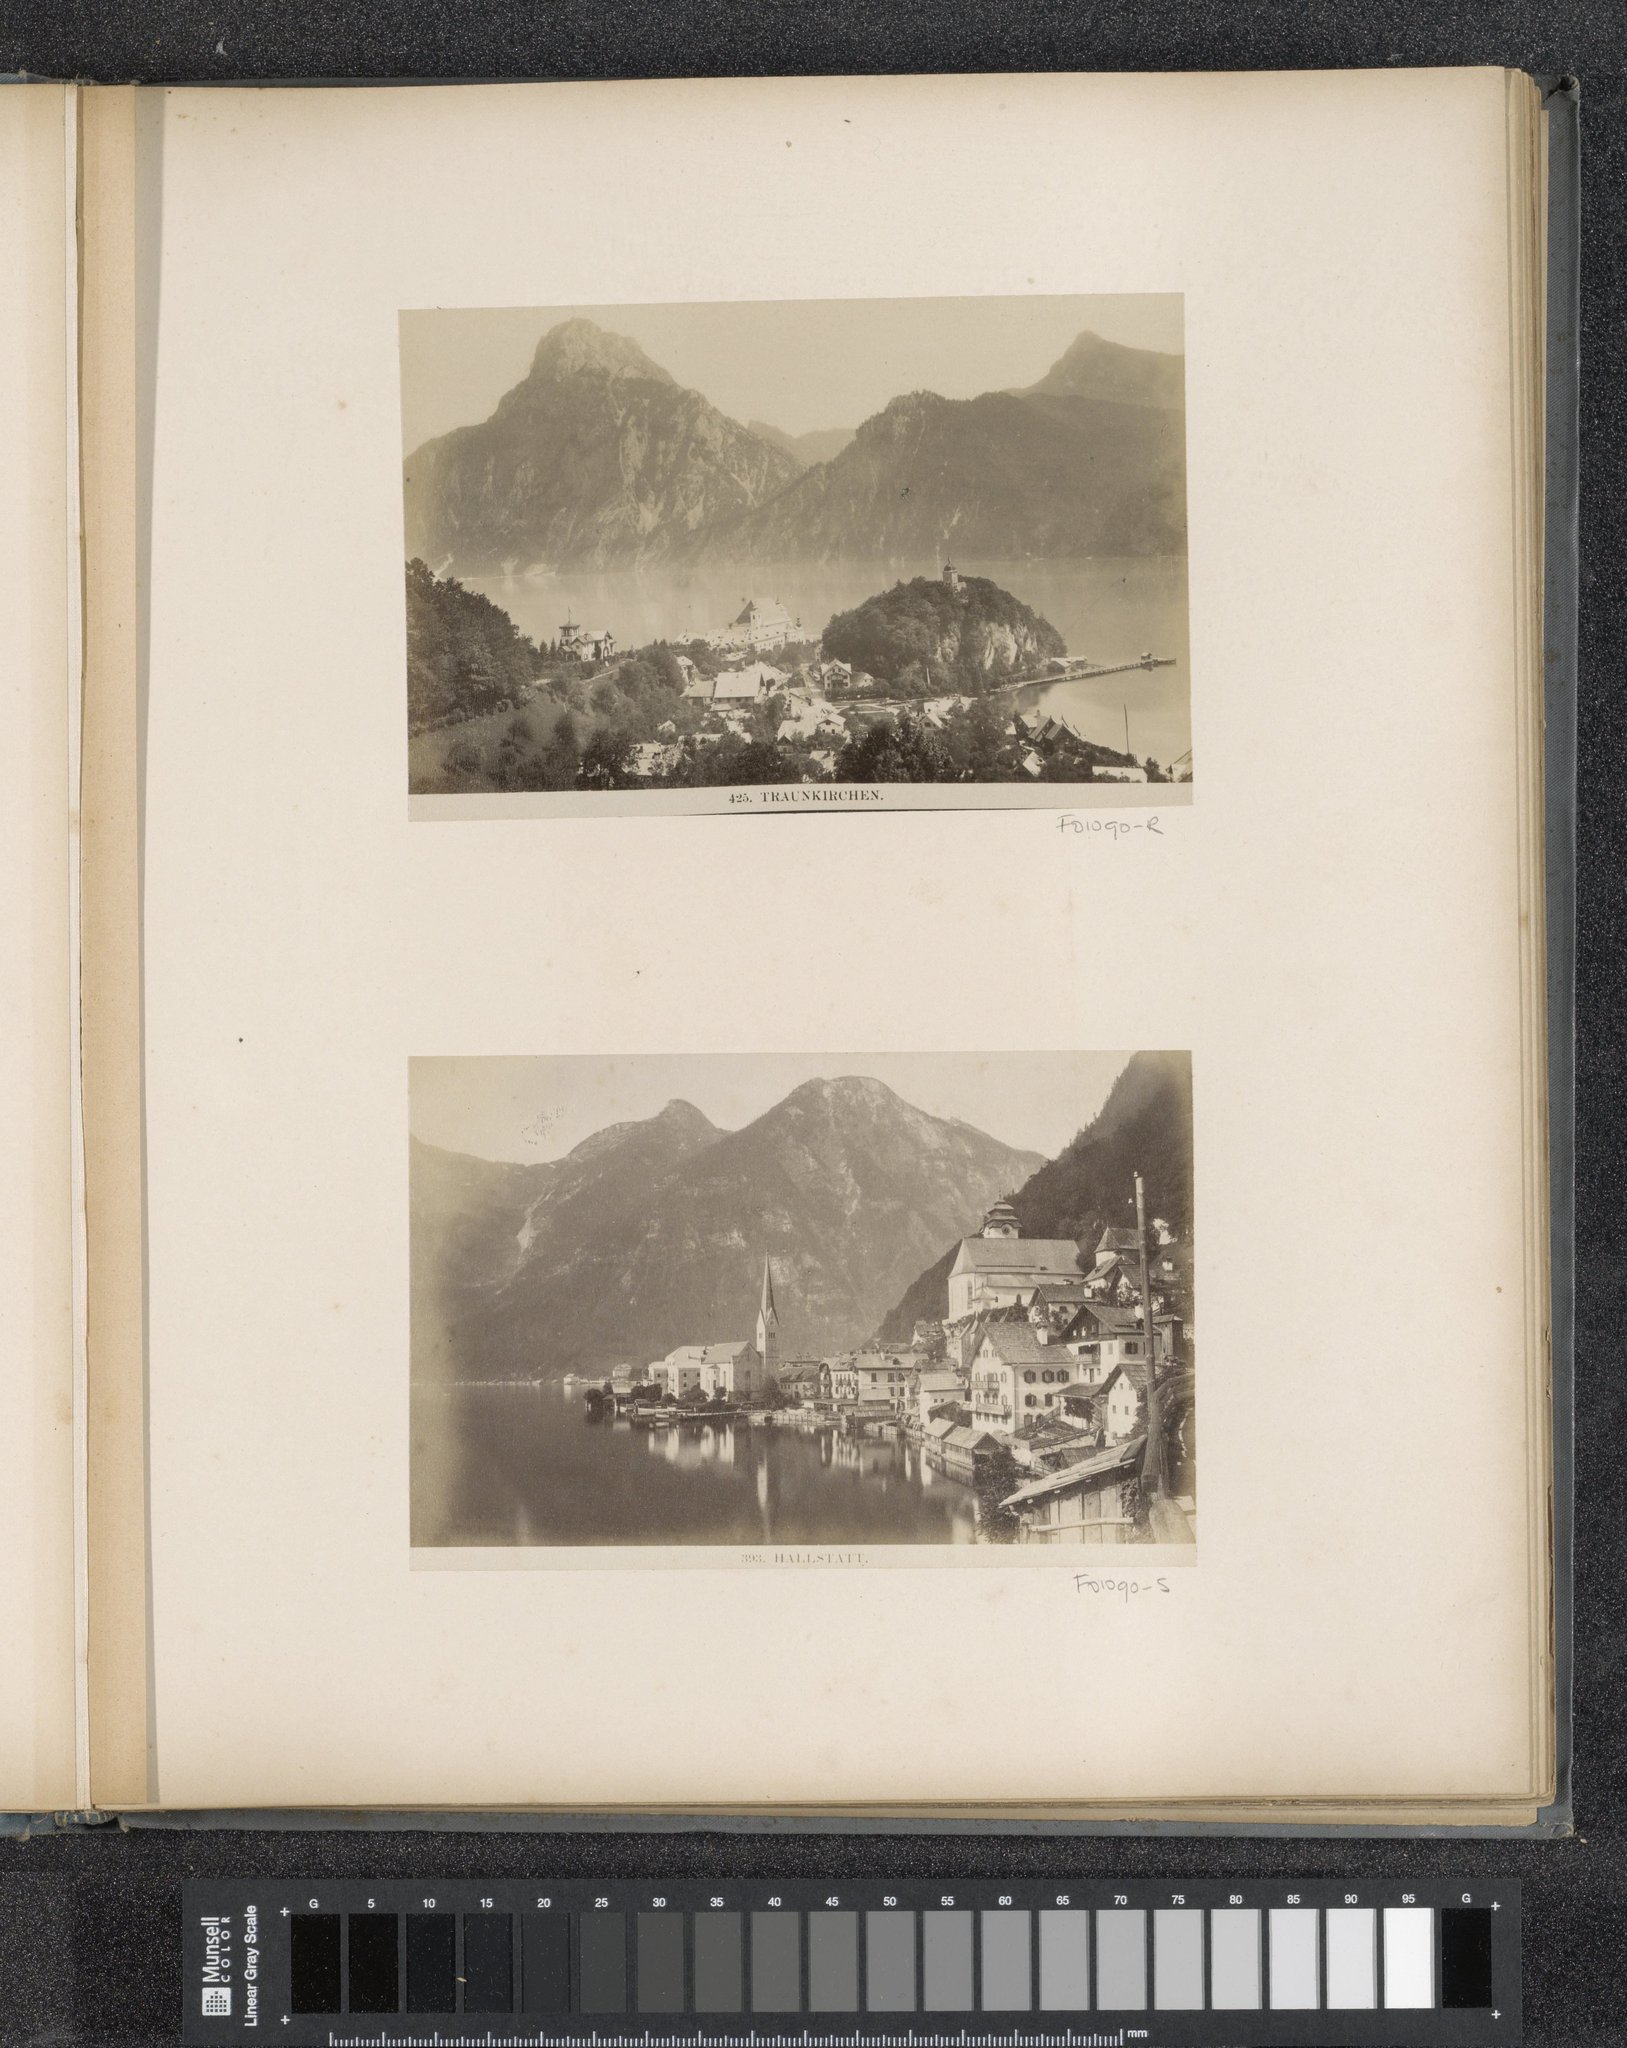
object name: photograph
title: Hallstatt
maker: Anonymous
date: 1870-1900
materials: paper, photographic support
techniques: albumen print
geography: hallstatt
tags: prospect of village, silhouette of village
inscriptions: negative number: ‘393’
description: Onderdeel van Reisalbum met foto's van bezienswaardigheden in Duitsland en Oostenrijk en van kunstwerken.